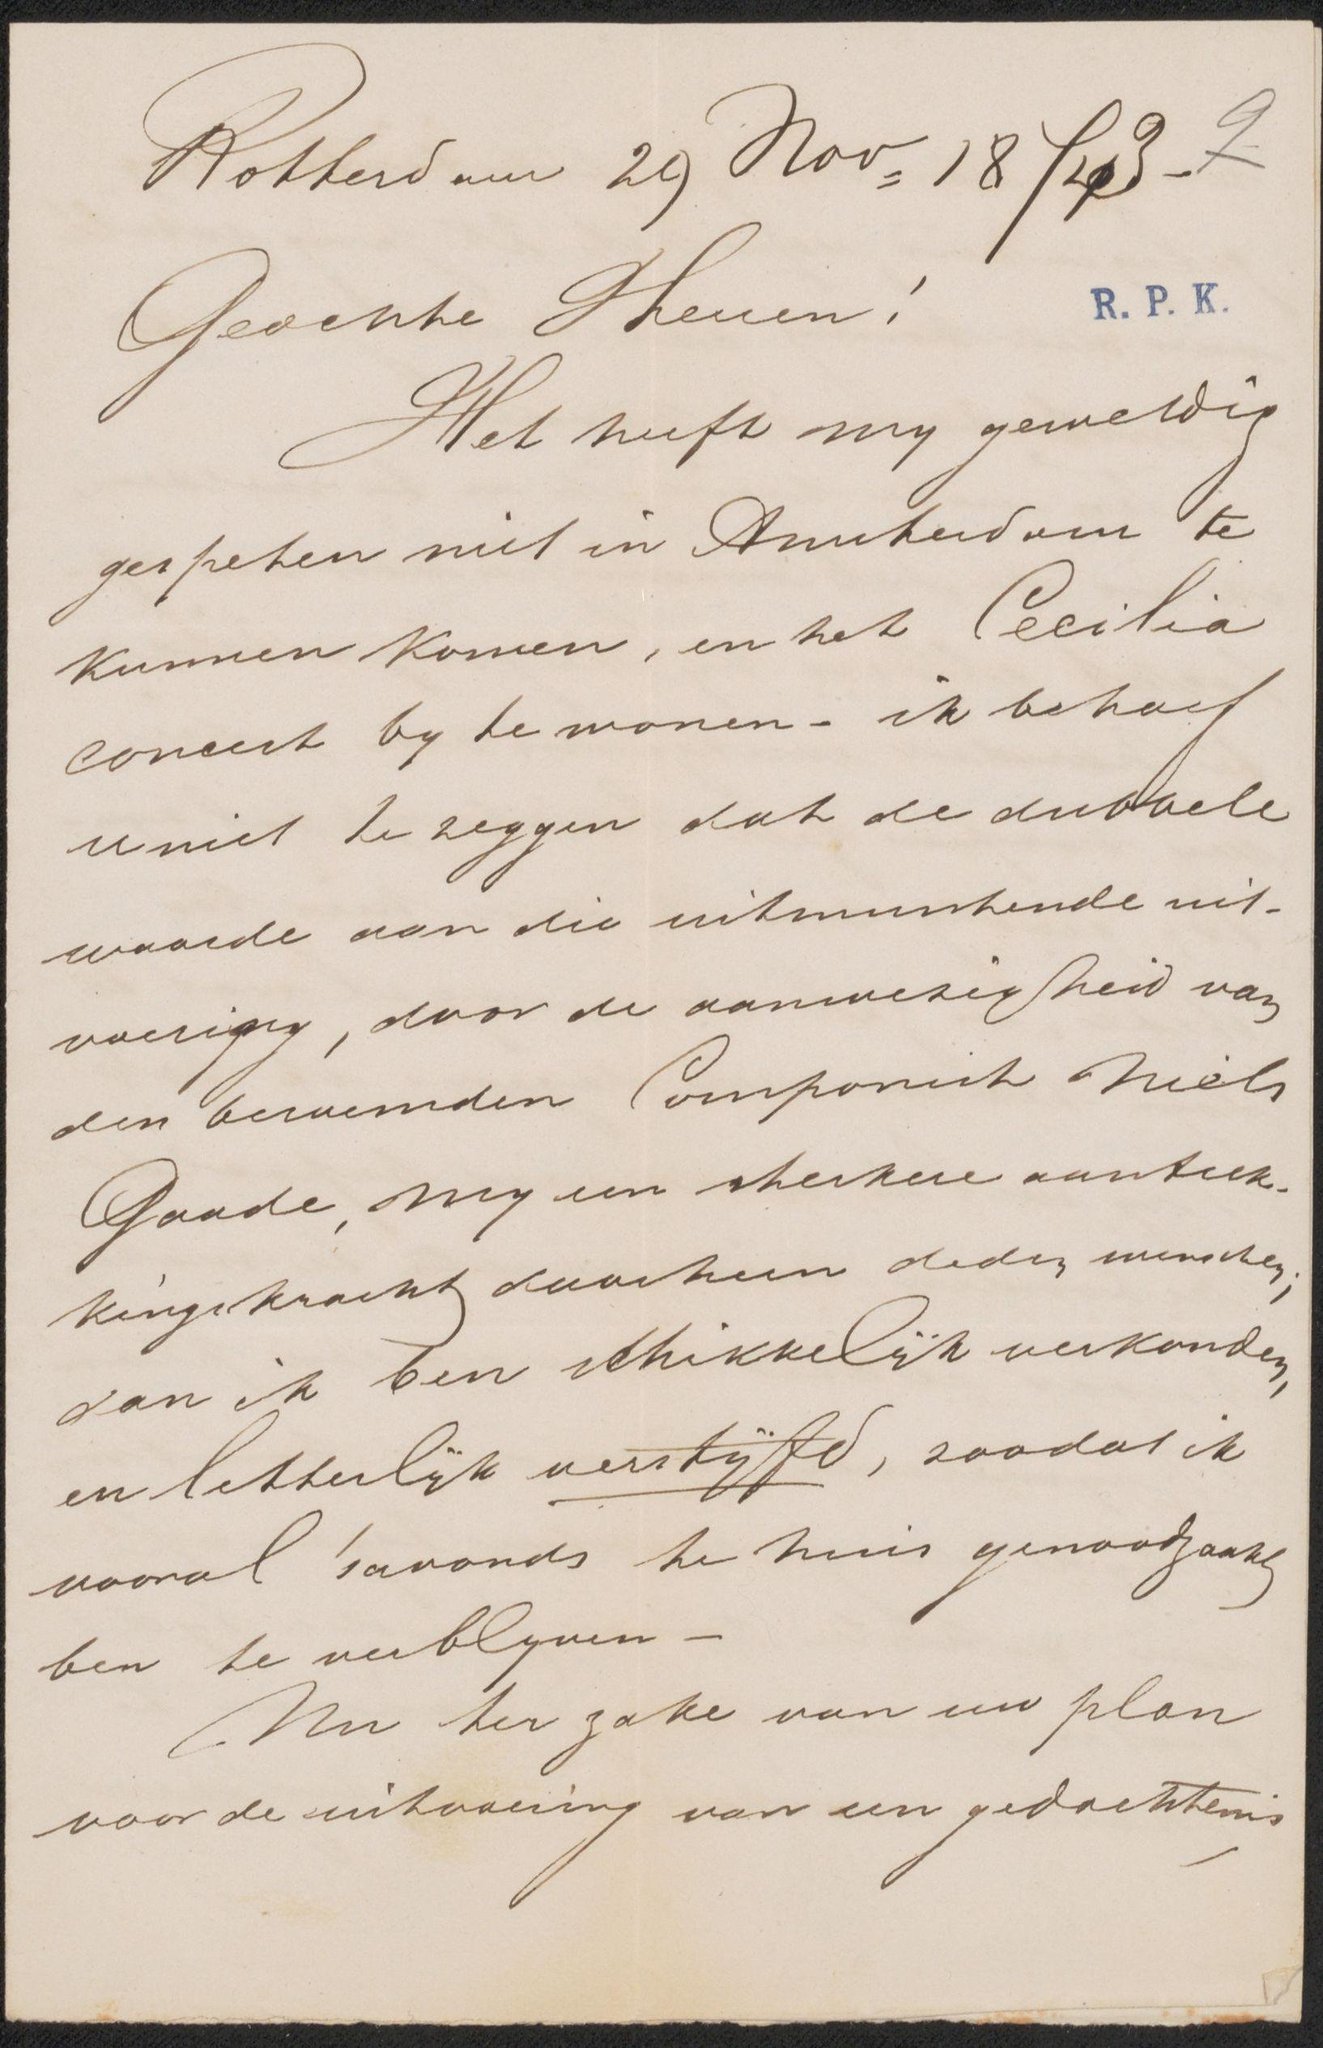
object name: letter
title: Brief aan Frans Buffa en Zonen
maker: charles rochussen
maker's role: draughtsman, painter, print maker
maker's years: 1814-1894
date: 1873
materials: ink, paper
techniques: pen, writing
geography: rotterdam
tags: copenhagen (city), publisher, the hague, william ii of the netherlands, music, money, amsterdam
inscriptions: collector's mark: Lugt 2233